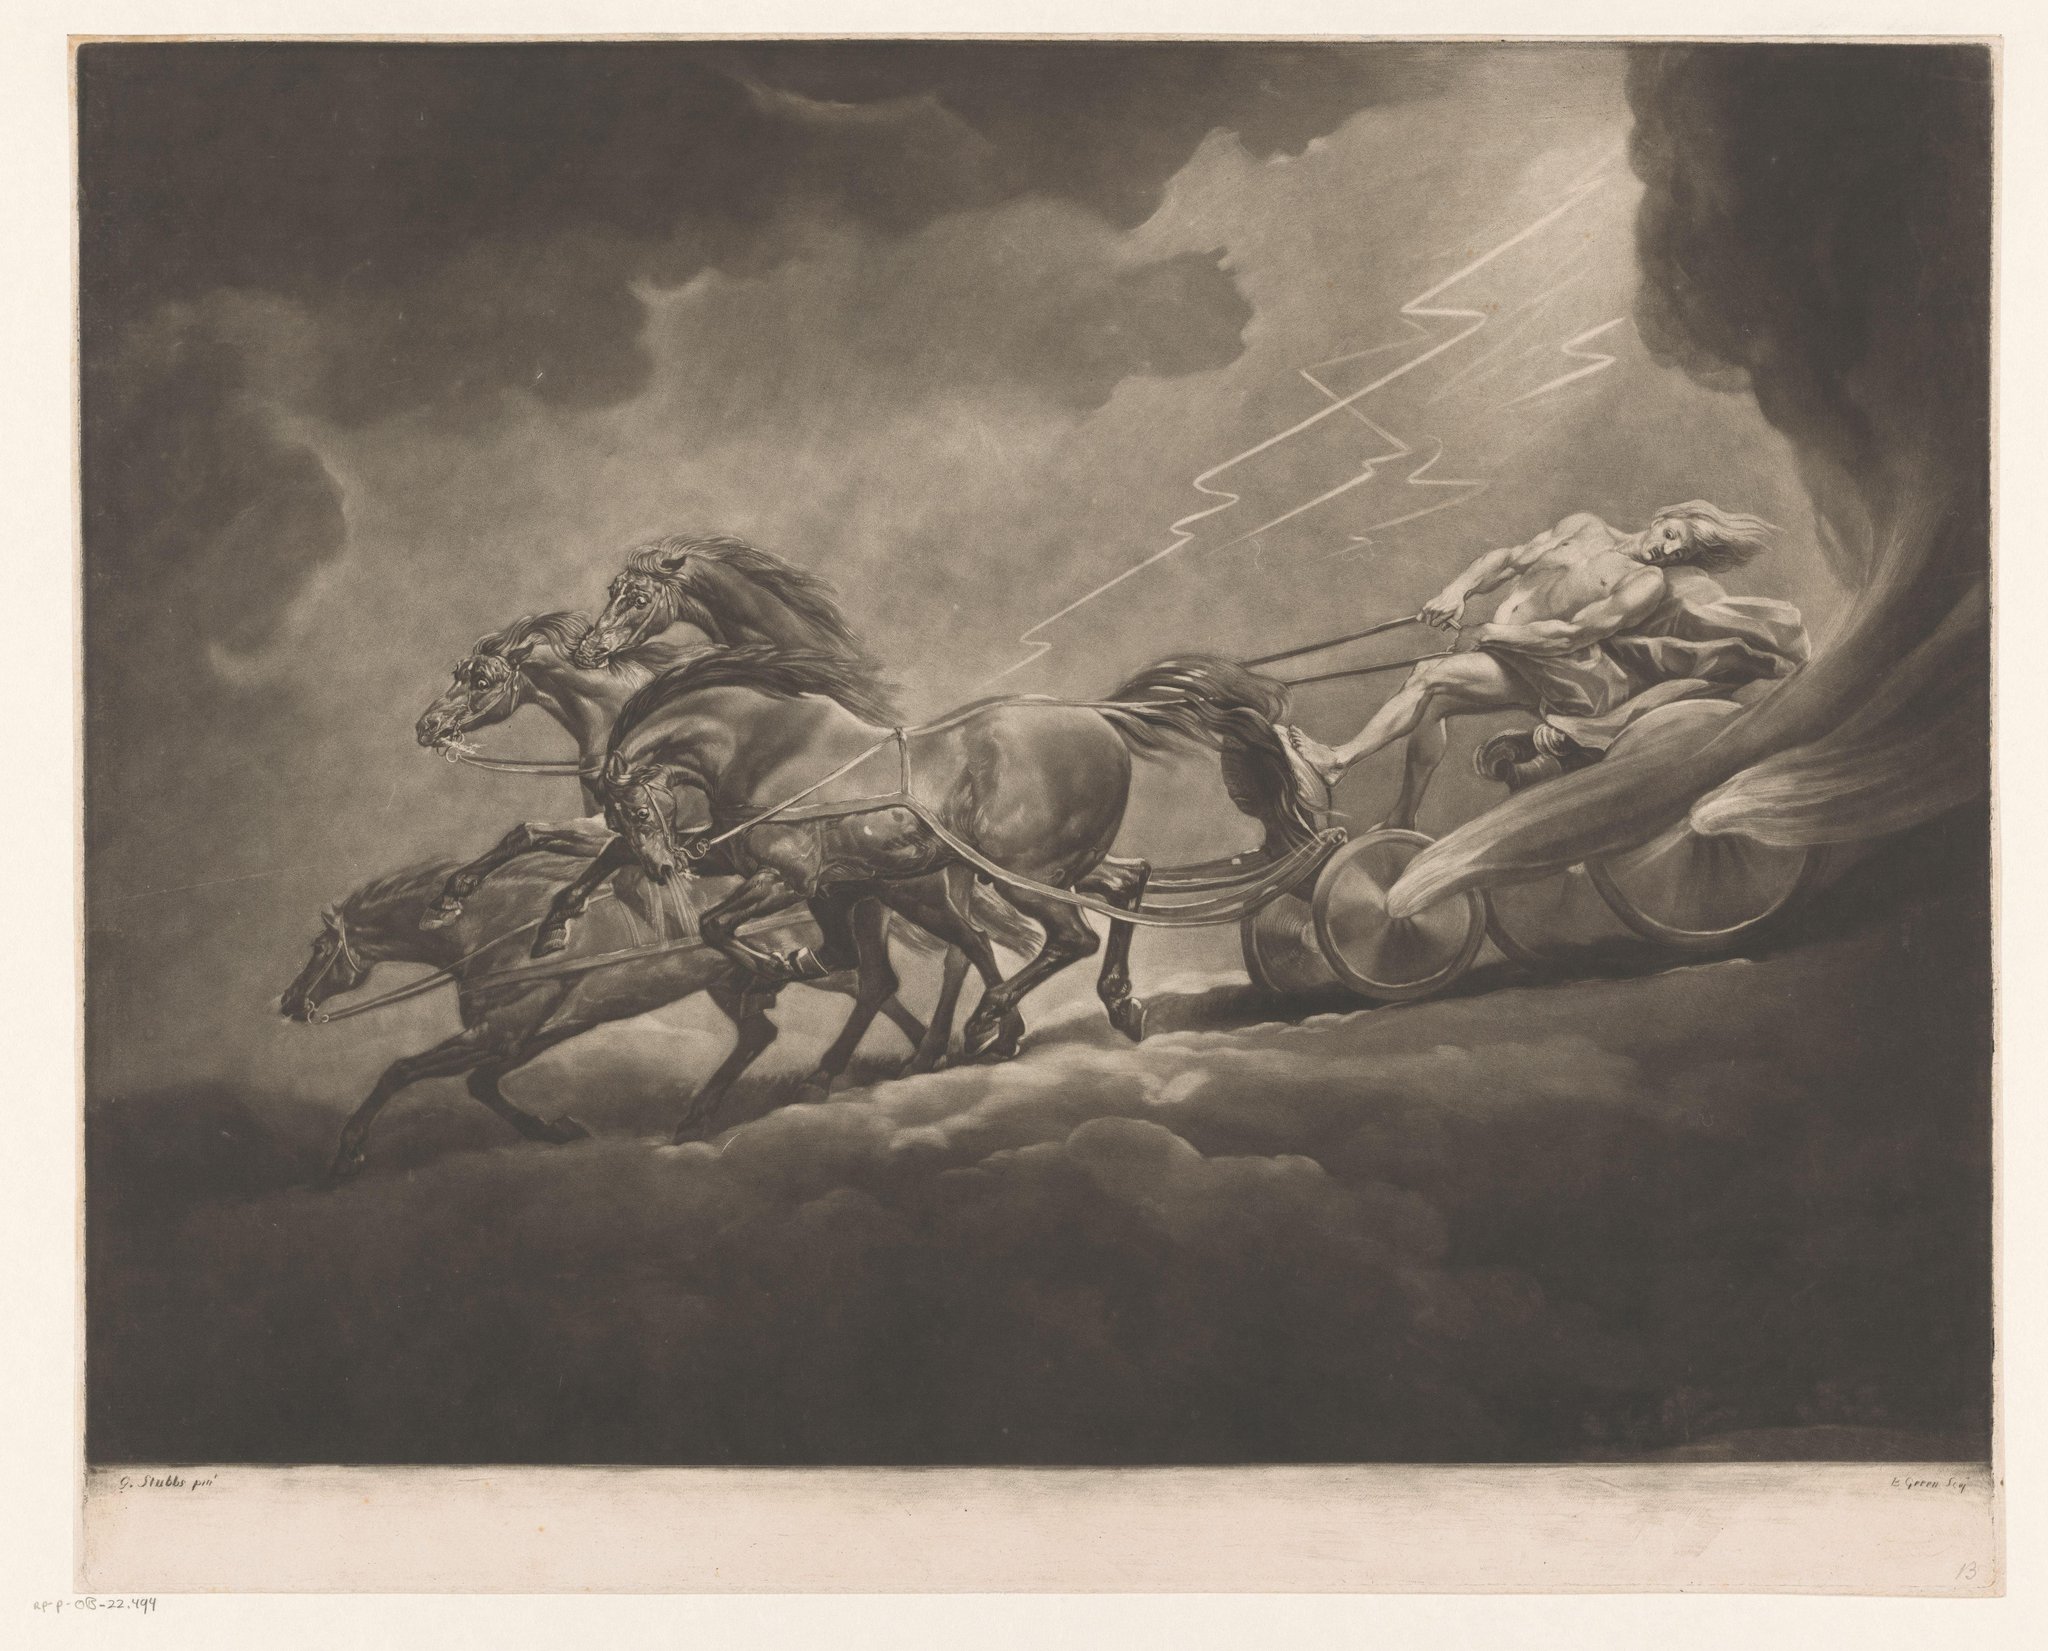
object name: print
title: Phaëton in de zonnewagen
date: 1765-1766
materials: paper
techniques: mezzotint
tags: fall of phaethon; he is struck by a thunderbolt of jupiter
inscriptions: collector's mark: Lugt 240